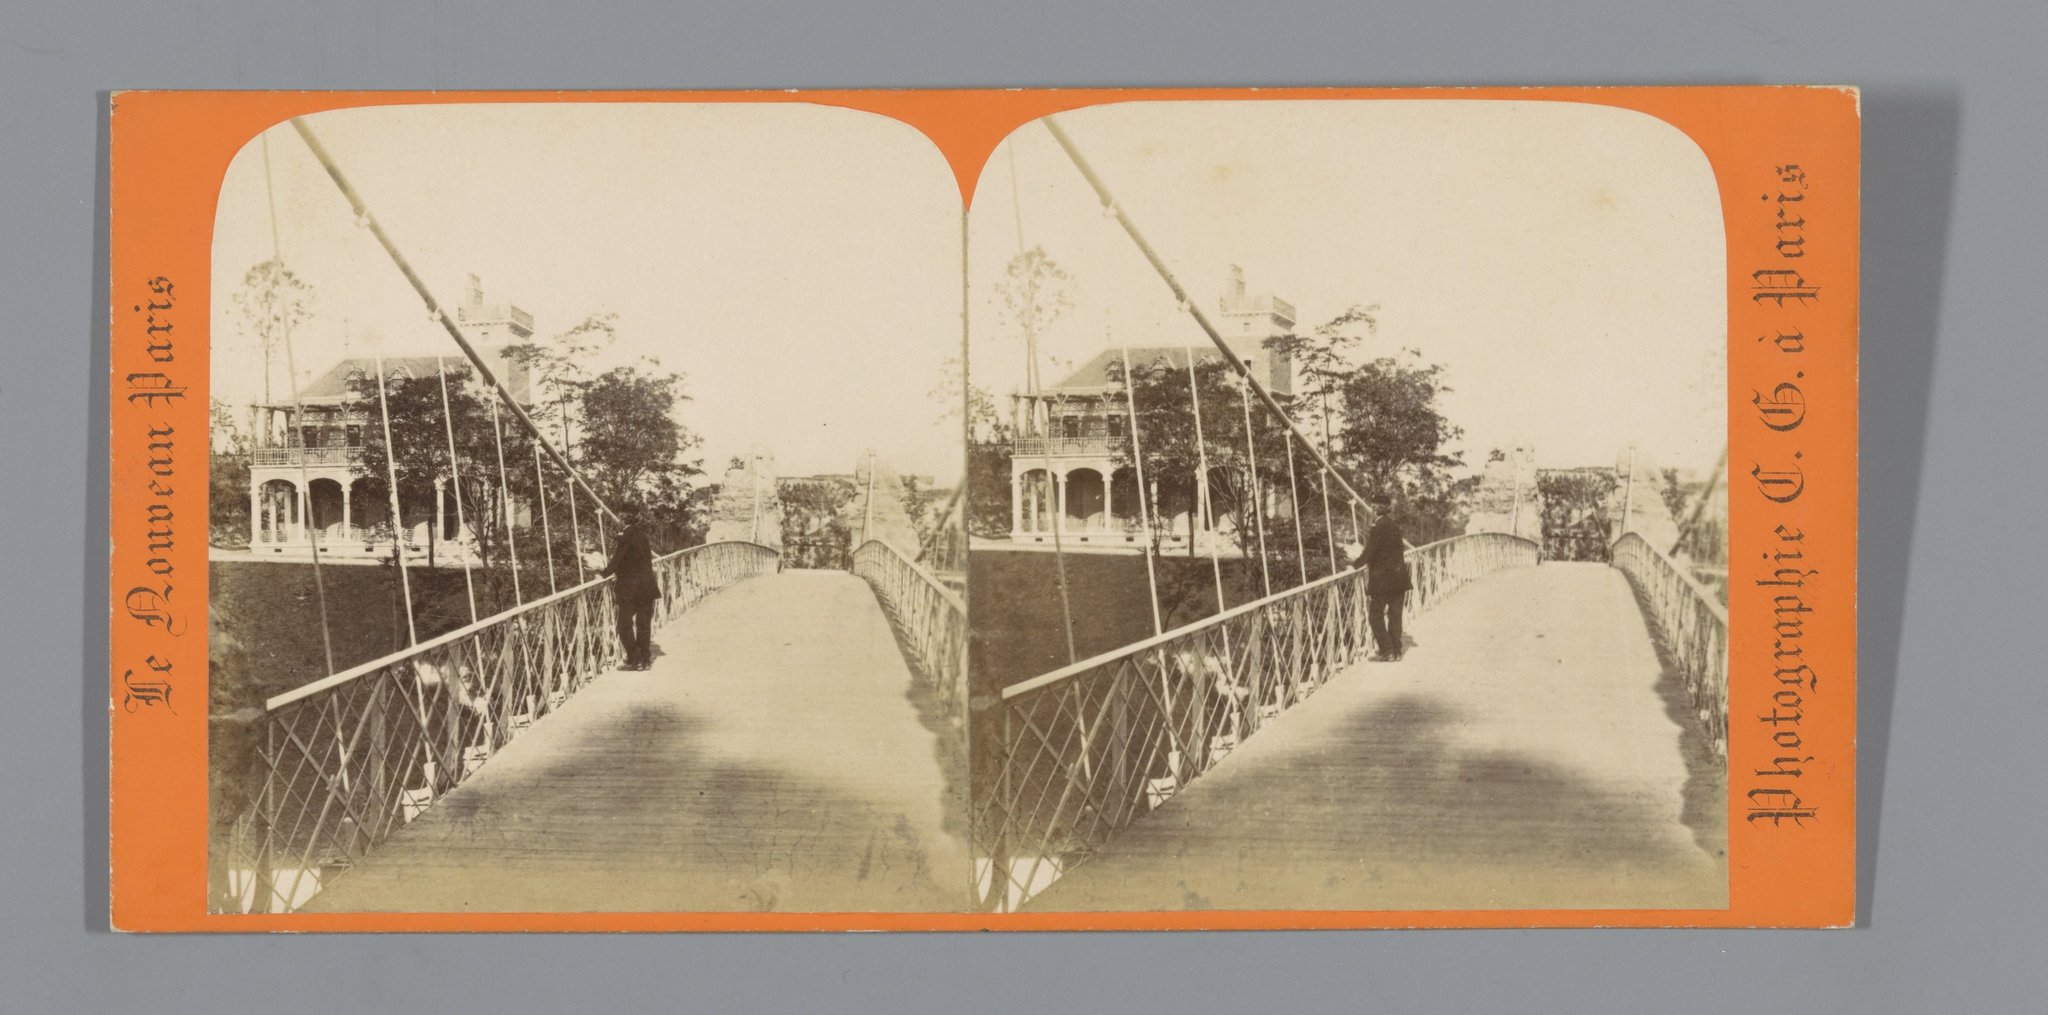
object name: stereograph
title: Brug in het Parc des Buttes-Chaumont te Parijs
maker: charles gérard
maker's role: fotograaf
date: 1860-1870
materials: cardboard, photographic support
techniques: albumen print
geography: parc des buttes-chaumont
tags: park, bridge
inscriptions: inscription: ‘Photographie C. G. à Paris.’, inscription: ‘Buttes Chaumont’